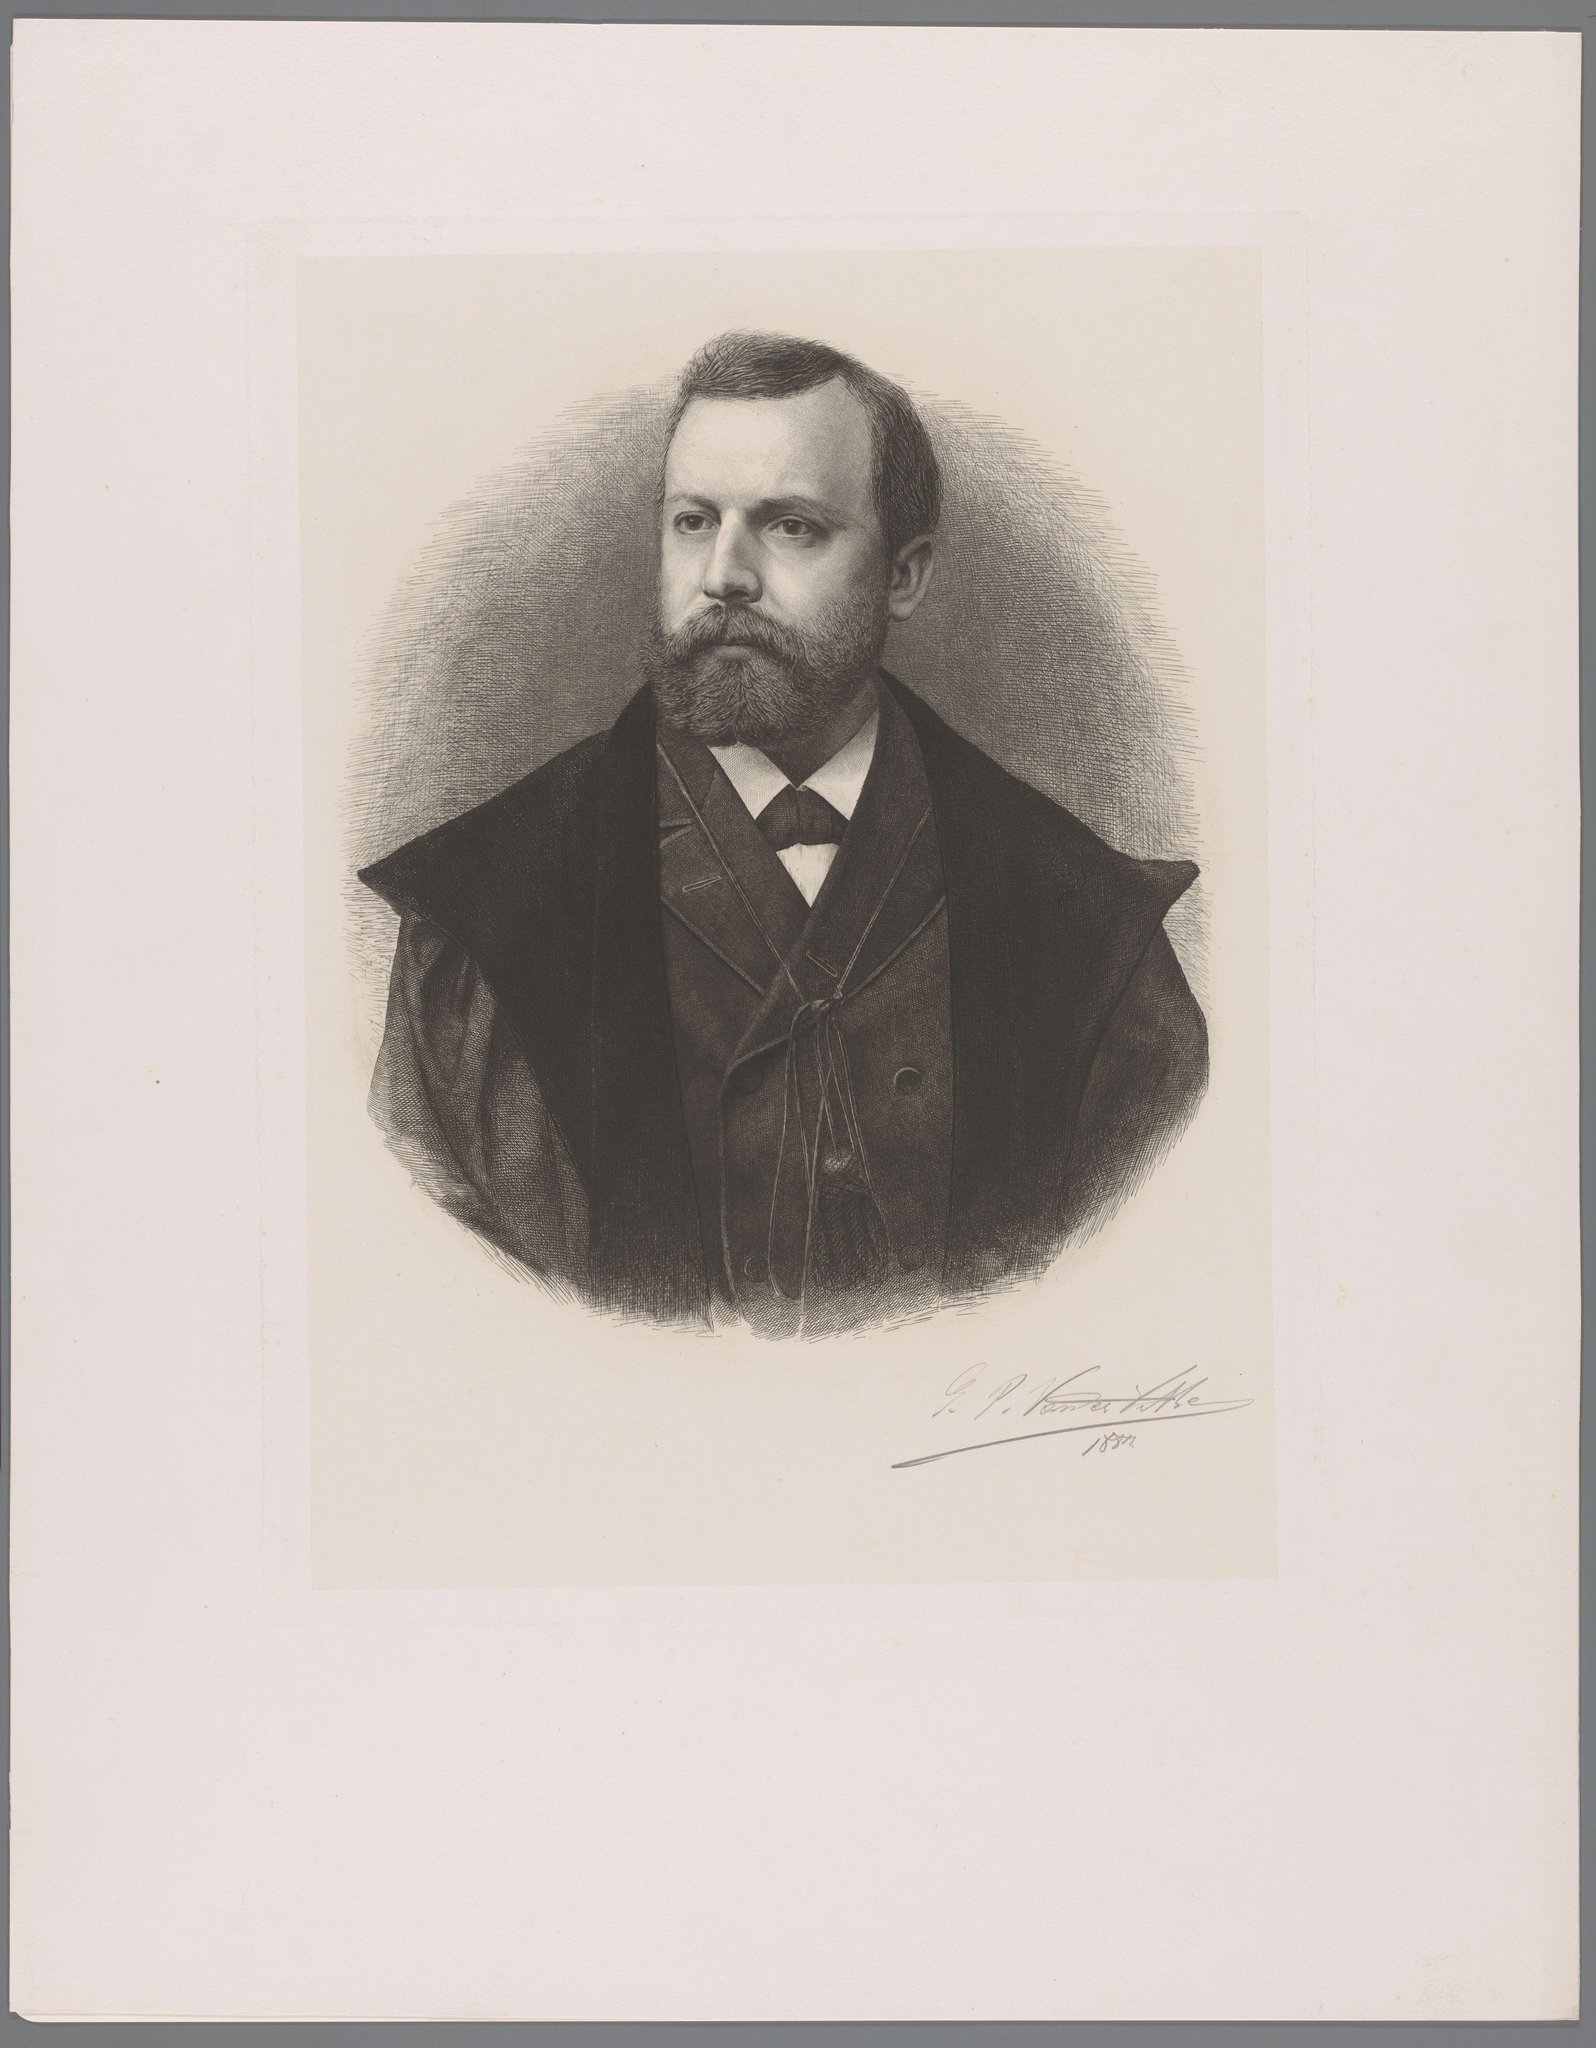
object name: print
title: Portret van een onbekende man, mogelijk Barsienno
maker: willem philip van der veken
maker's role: print maker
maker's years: 1863-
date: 1880-1889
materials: paper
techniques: etching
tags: adult man, historical persons, beard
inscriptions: collector's mark: Lugt 2228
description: In de inventaris opgenomen als: Barsienno.